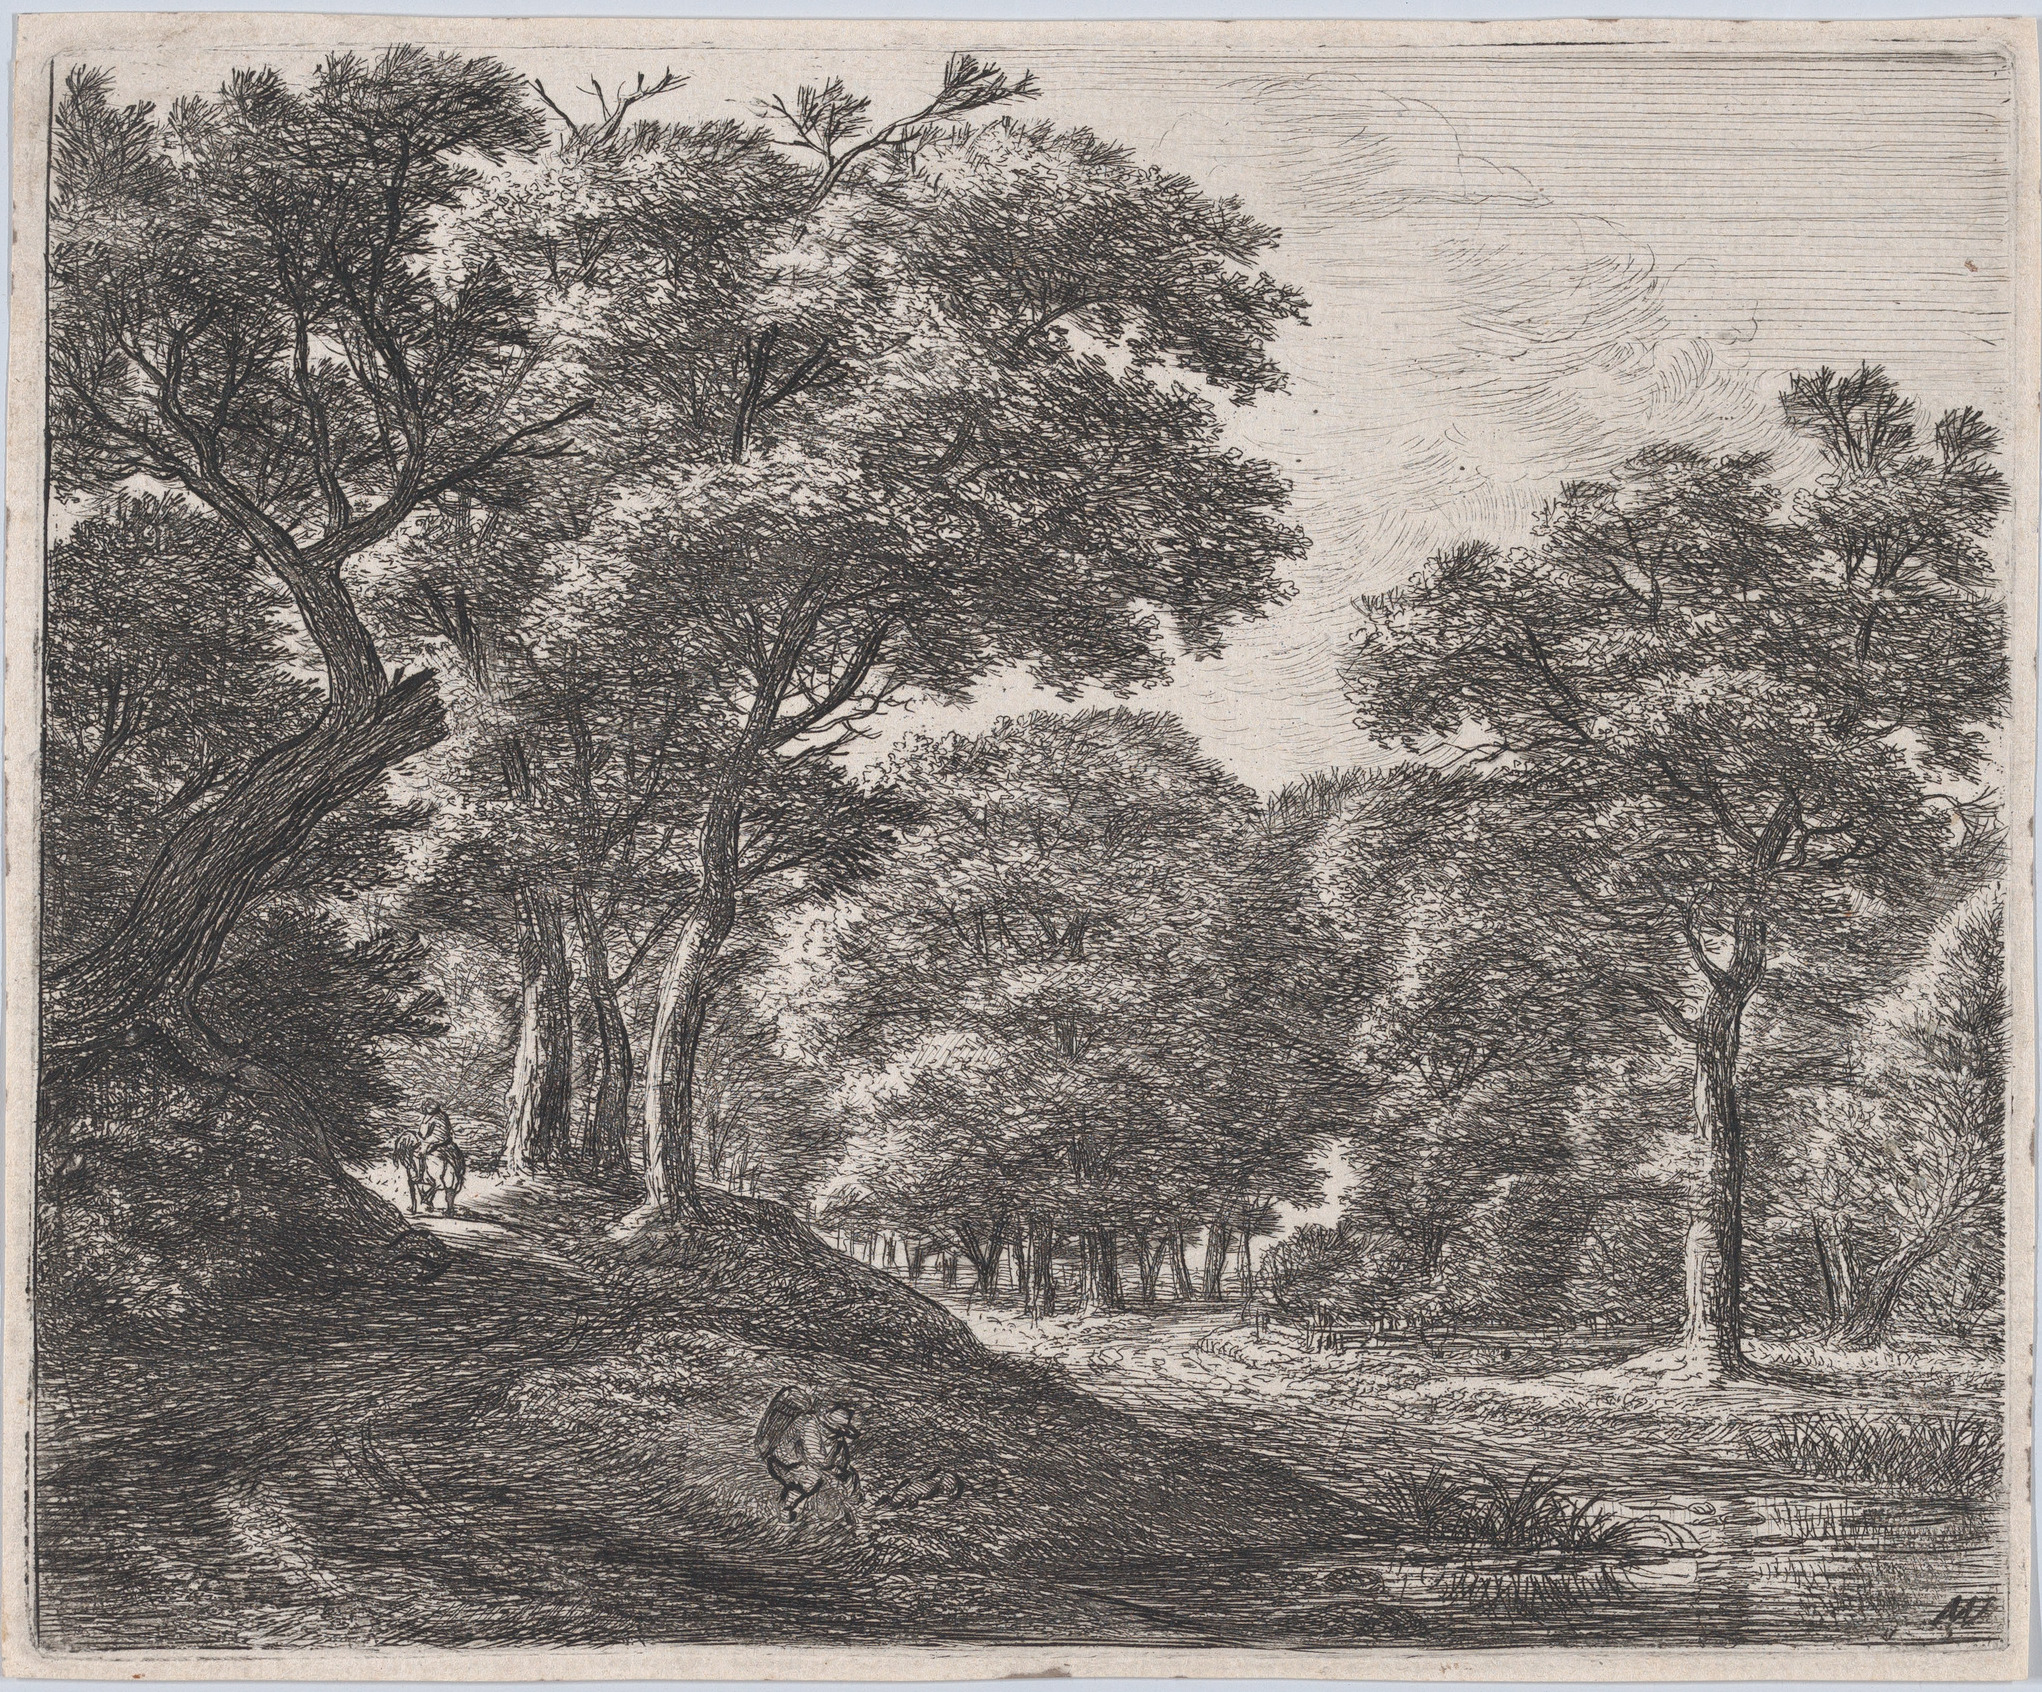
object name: print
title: Twilight in the Woods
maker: anthonie waterloo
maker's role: artist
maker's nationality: dutch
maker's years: 1609-1690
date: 1601-1700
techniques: etching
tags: landscapes